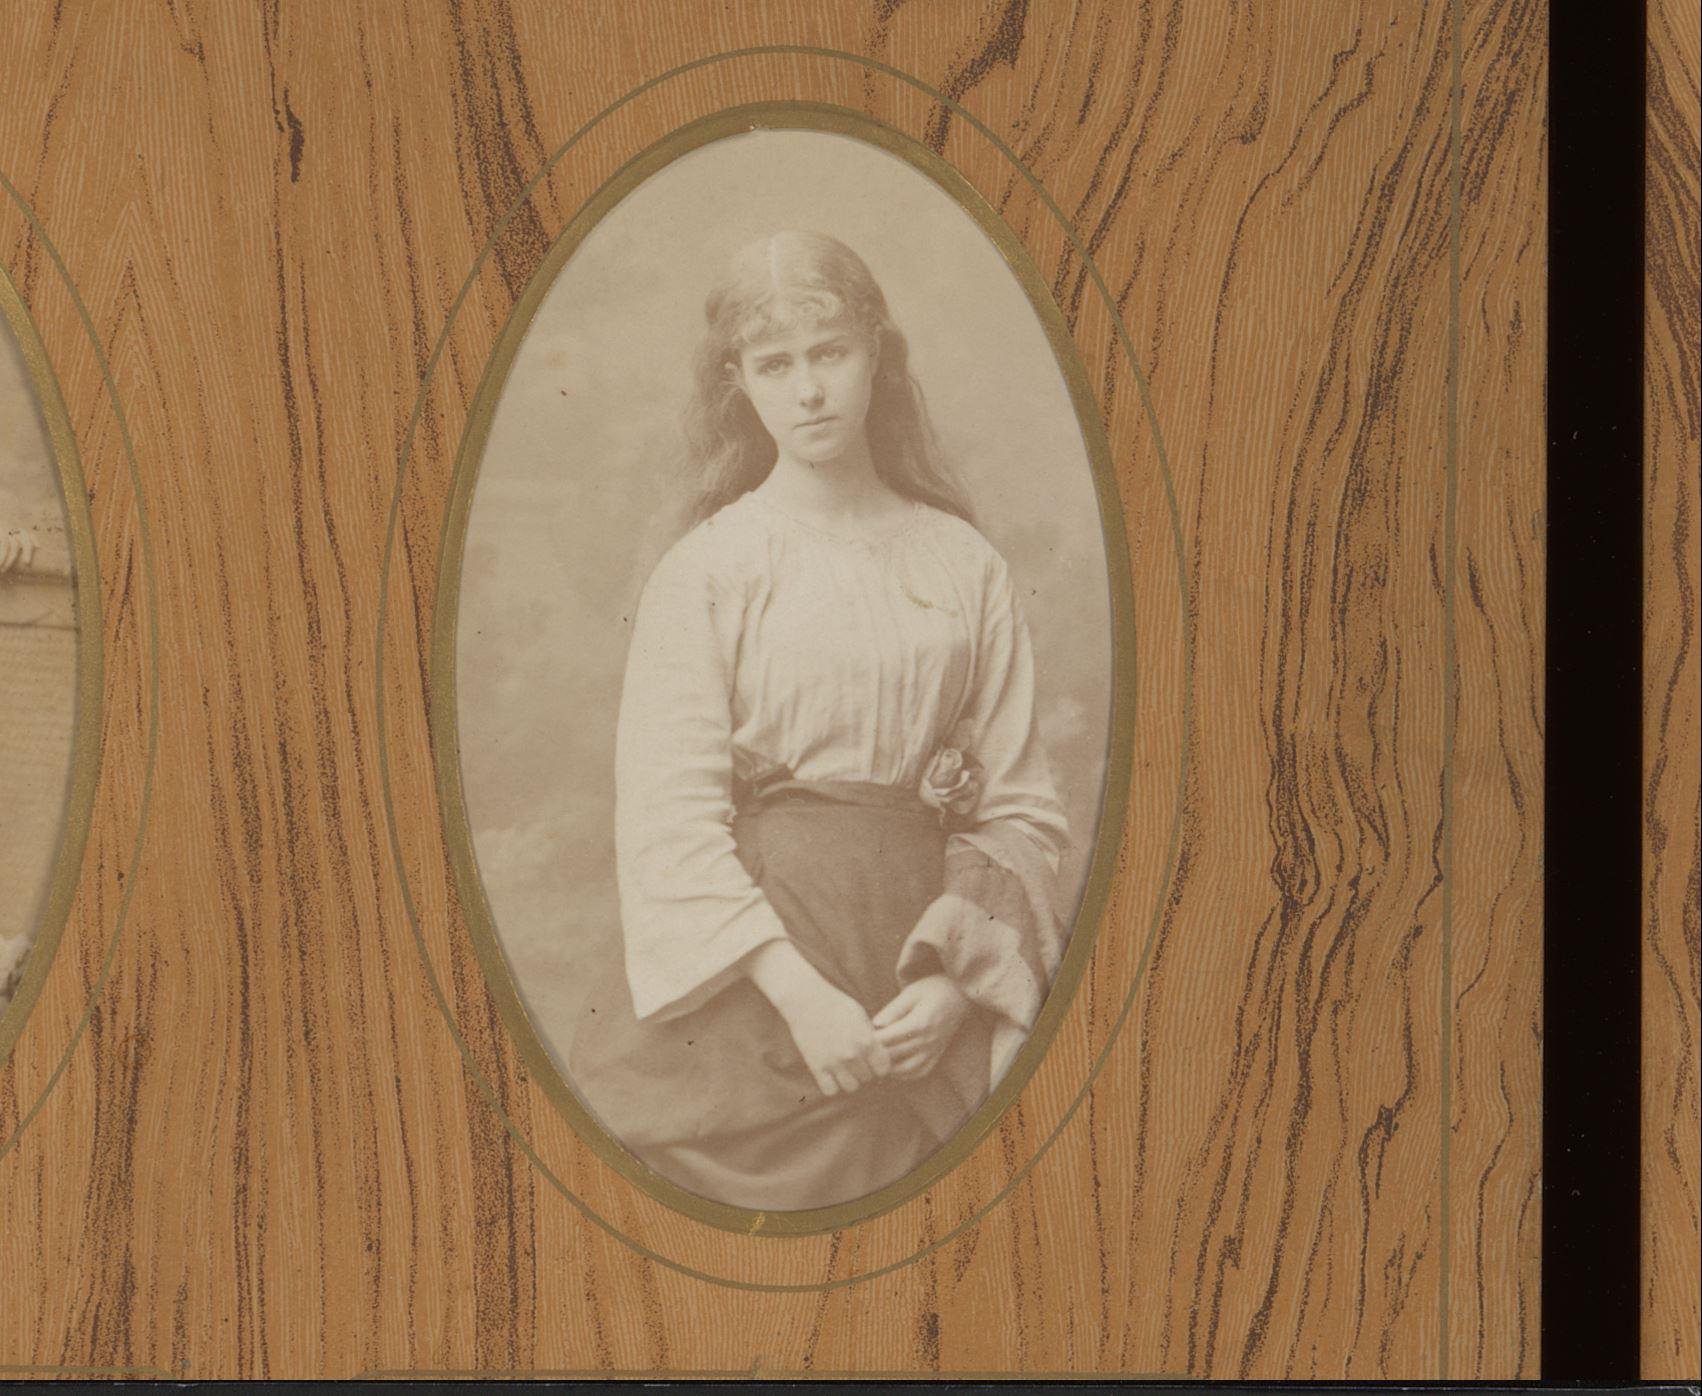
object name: photograph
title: Portret van een jonge vrouw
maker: otto van bosch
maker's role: fotograaf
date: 1880-1900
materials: cardboard, photographic support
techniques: albumen print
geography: paris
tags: historical persons - bb - woman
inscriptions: inscription: ‘Photographie/ van Bosch/ 35. Bould des Capucines/ Paris’, annotation: ‘Van[...]’, inscription: ‘E. HAUTE COEUR/ 35, Av. de l'Opéra/ PARIS’